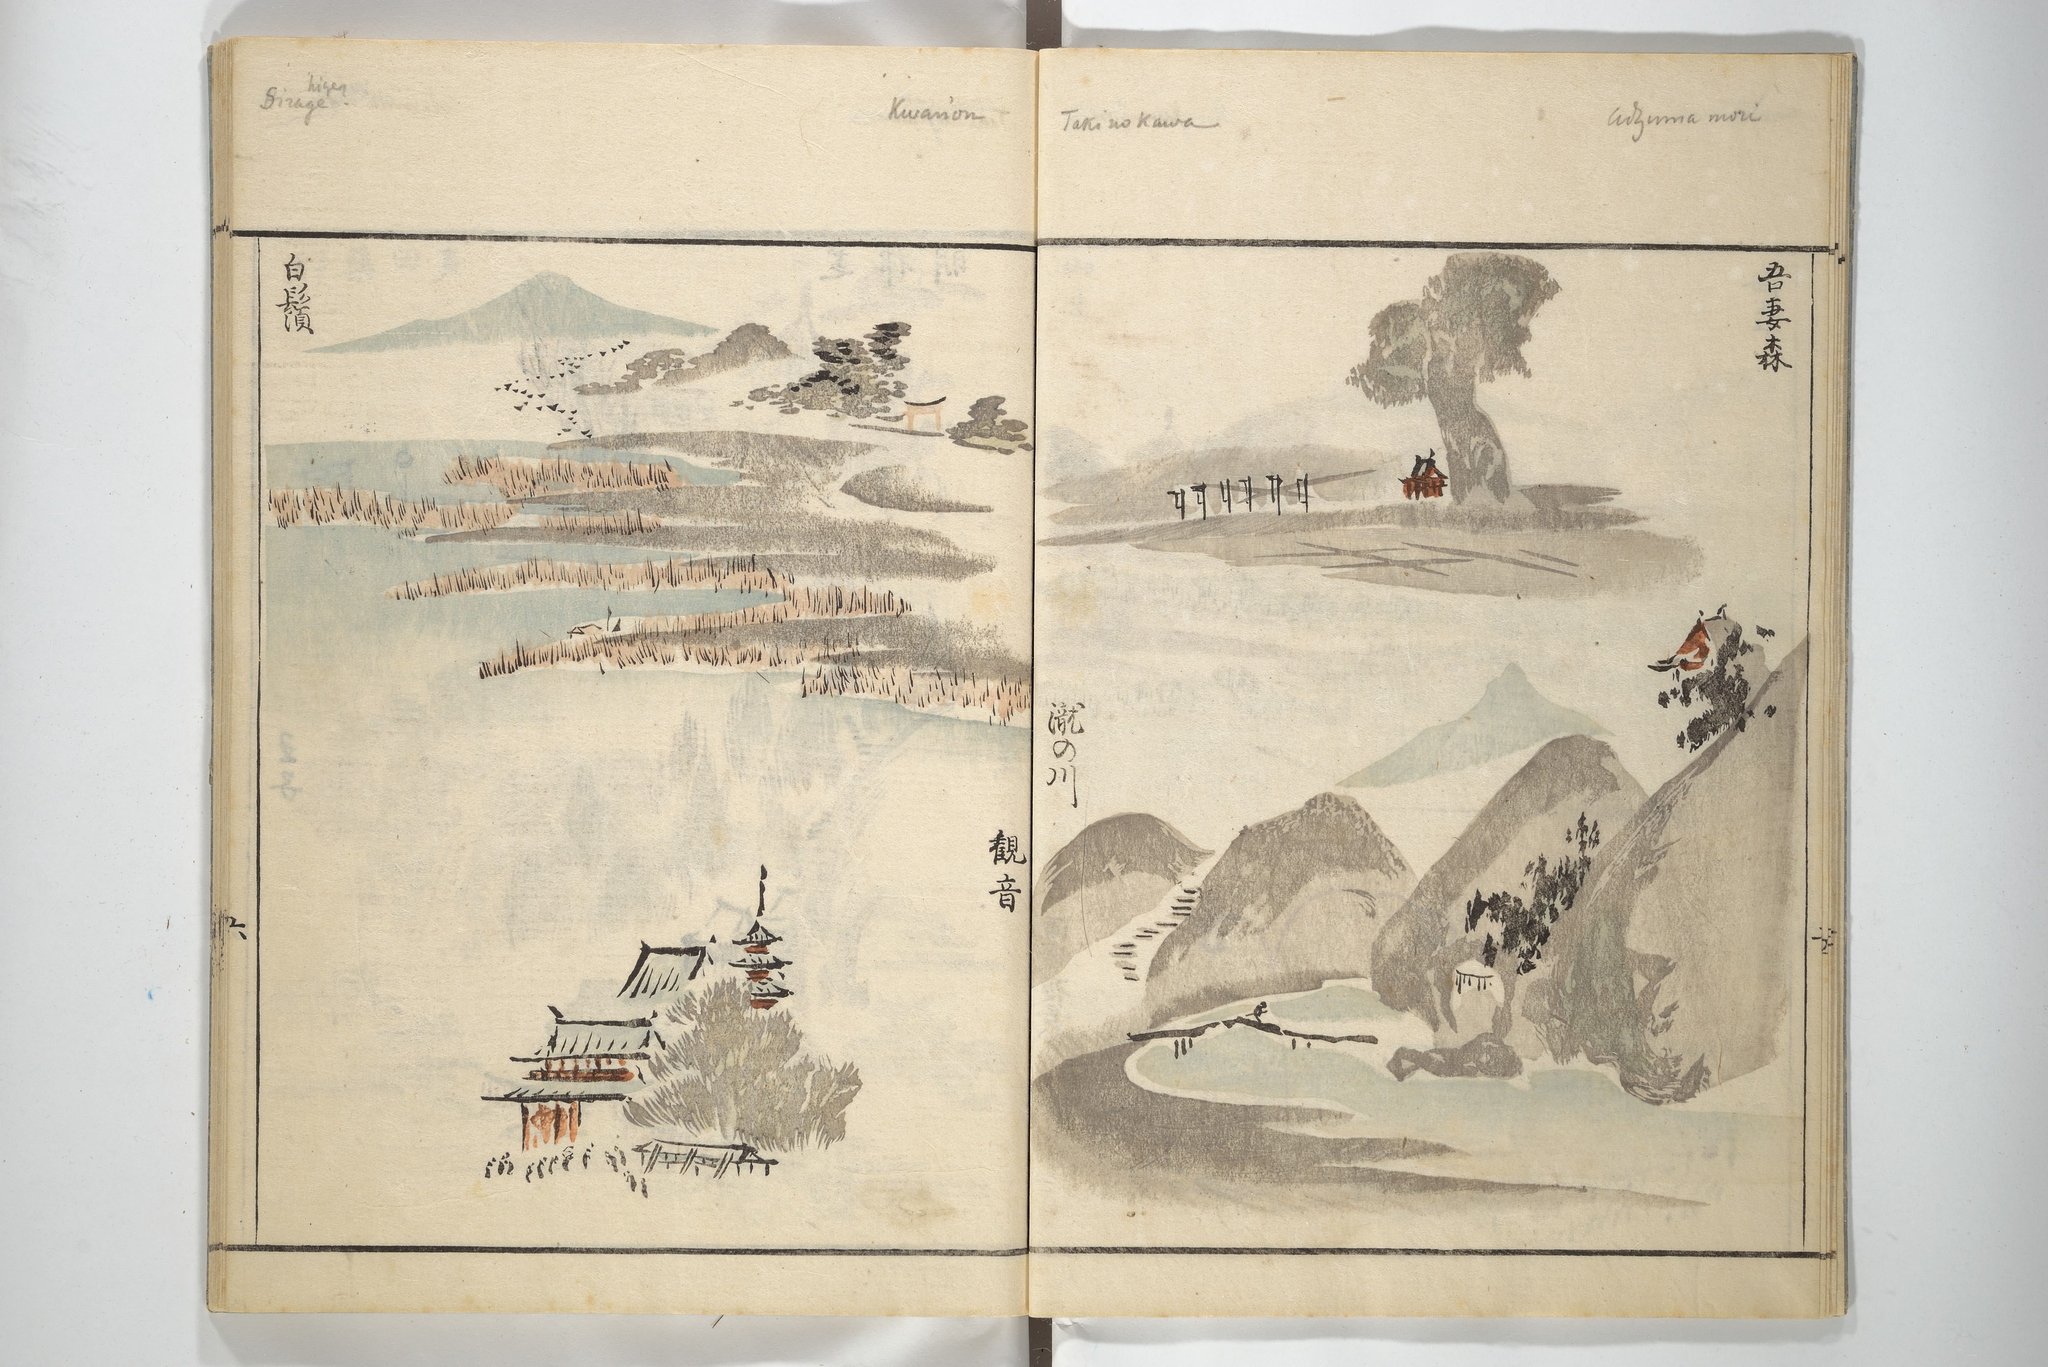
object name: illustrated book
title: How to Draw Landscapes Simply (Sansui ryakugashiki) 山水略画式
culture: japanese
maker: kuwagata keisai 鍬形蕙斎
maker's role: artist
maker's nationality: japanese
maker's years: 1764-1824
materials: ink, paper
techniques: woodblock print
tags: landscapes